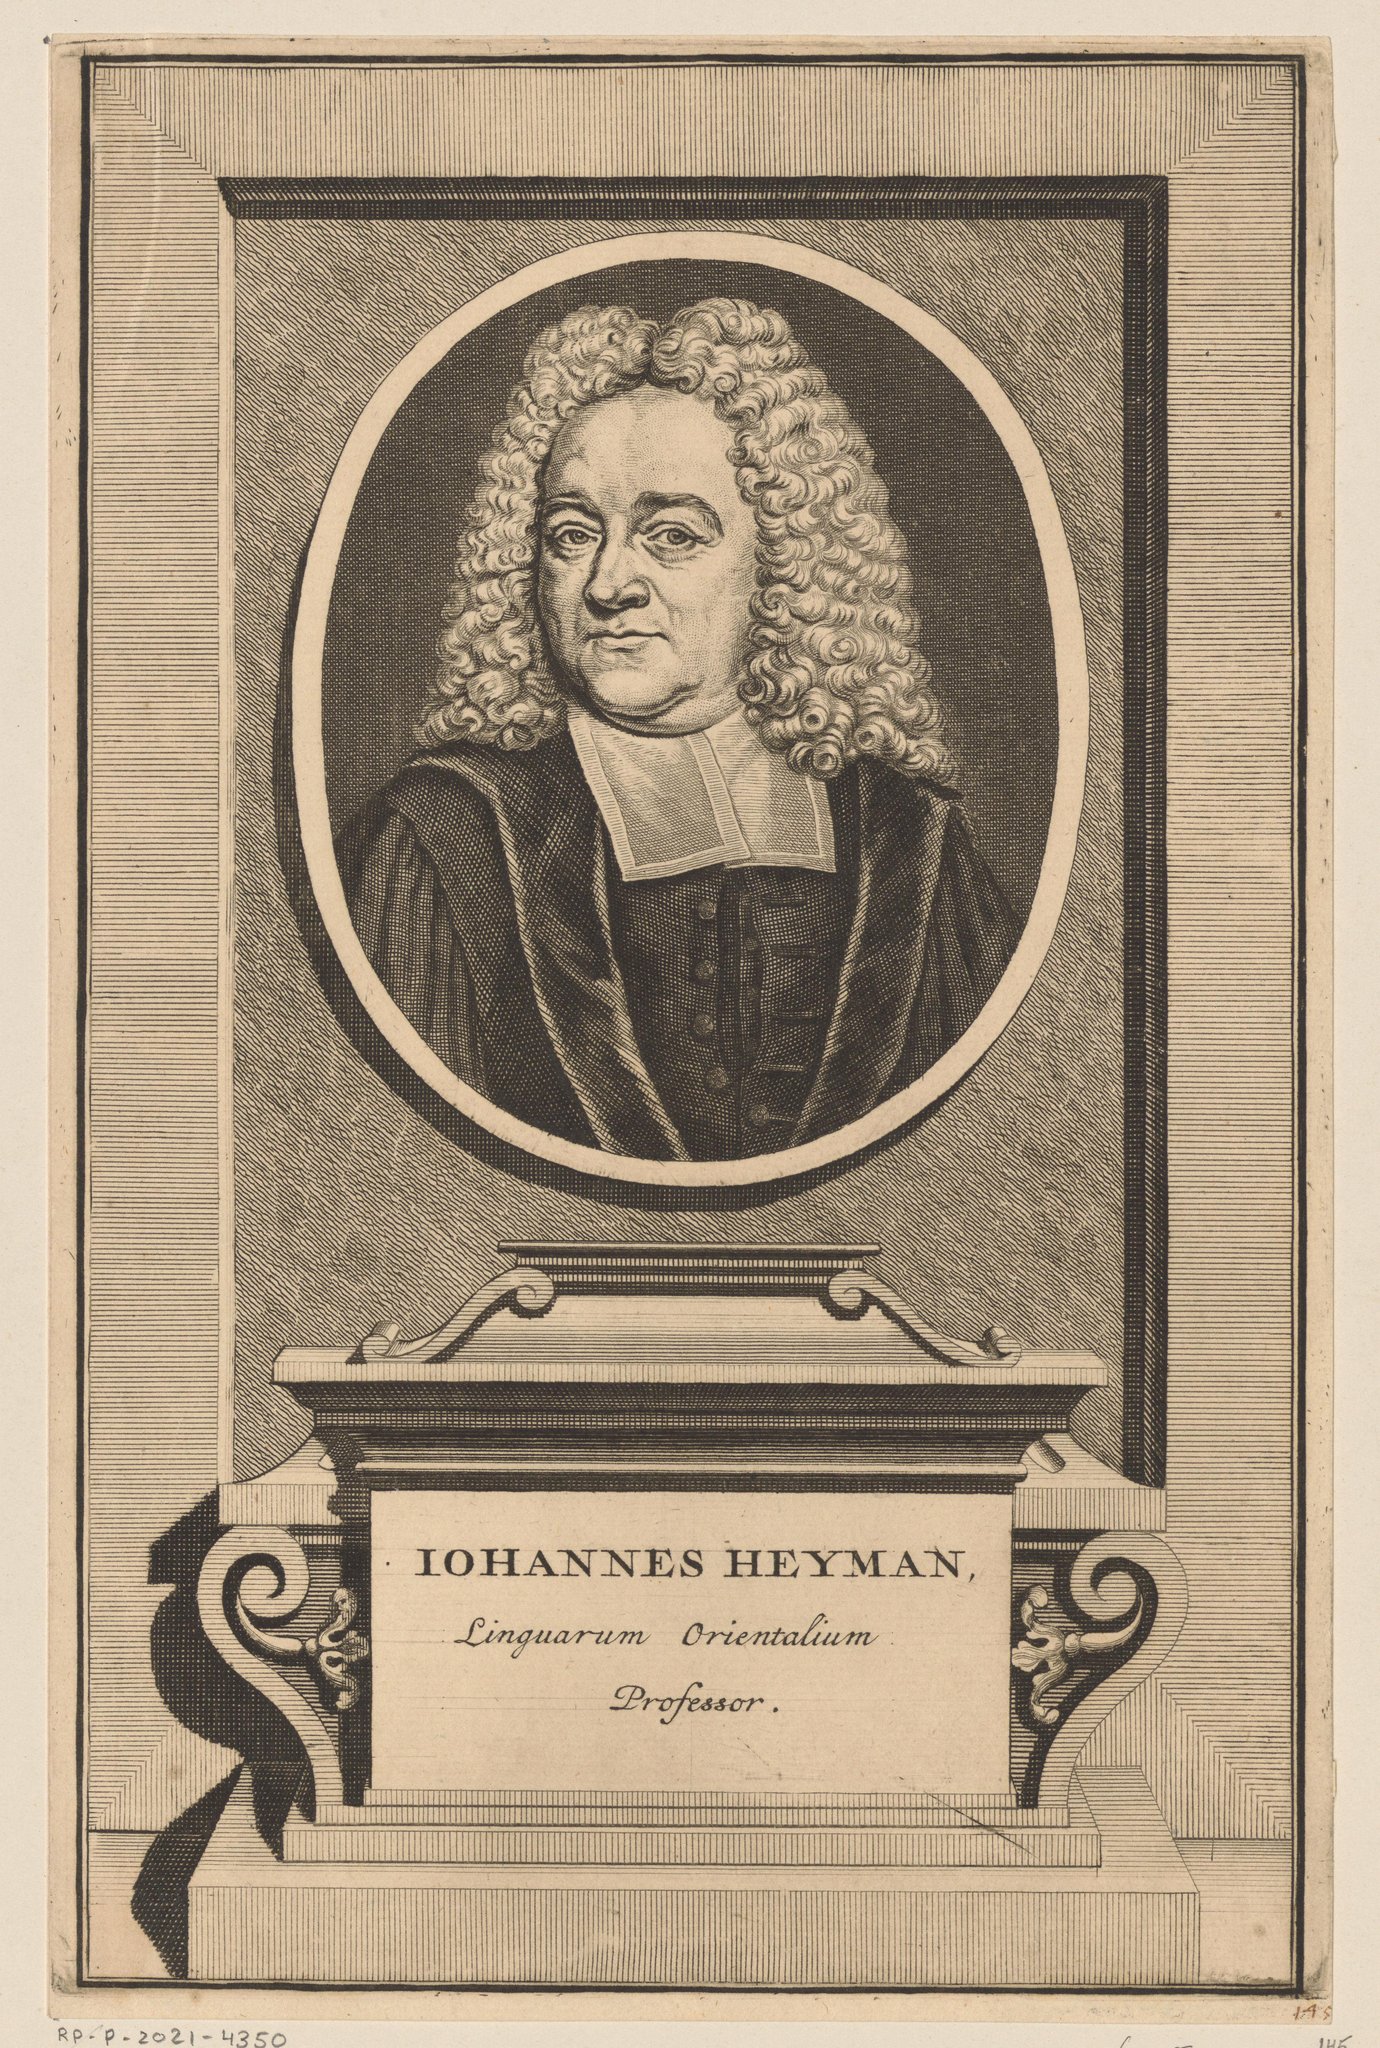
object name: print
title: Fundatoris, curatorum et professorum celeberrimorum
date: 1716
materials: paper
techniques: engraving, etching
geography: leiden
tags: historical persons, professor